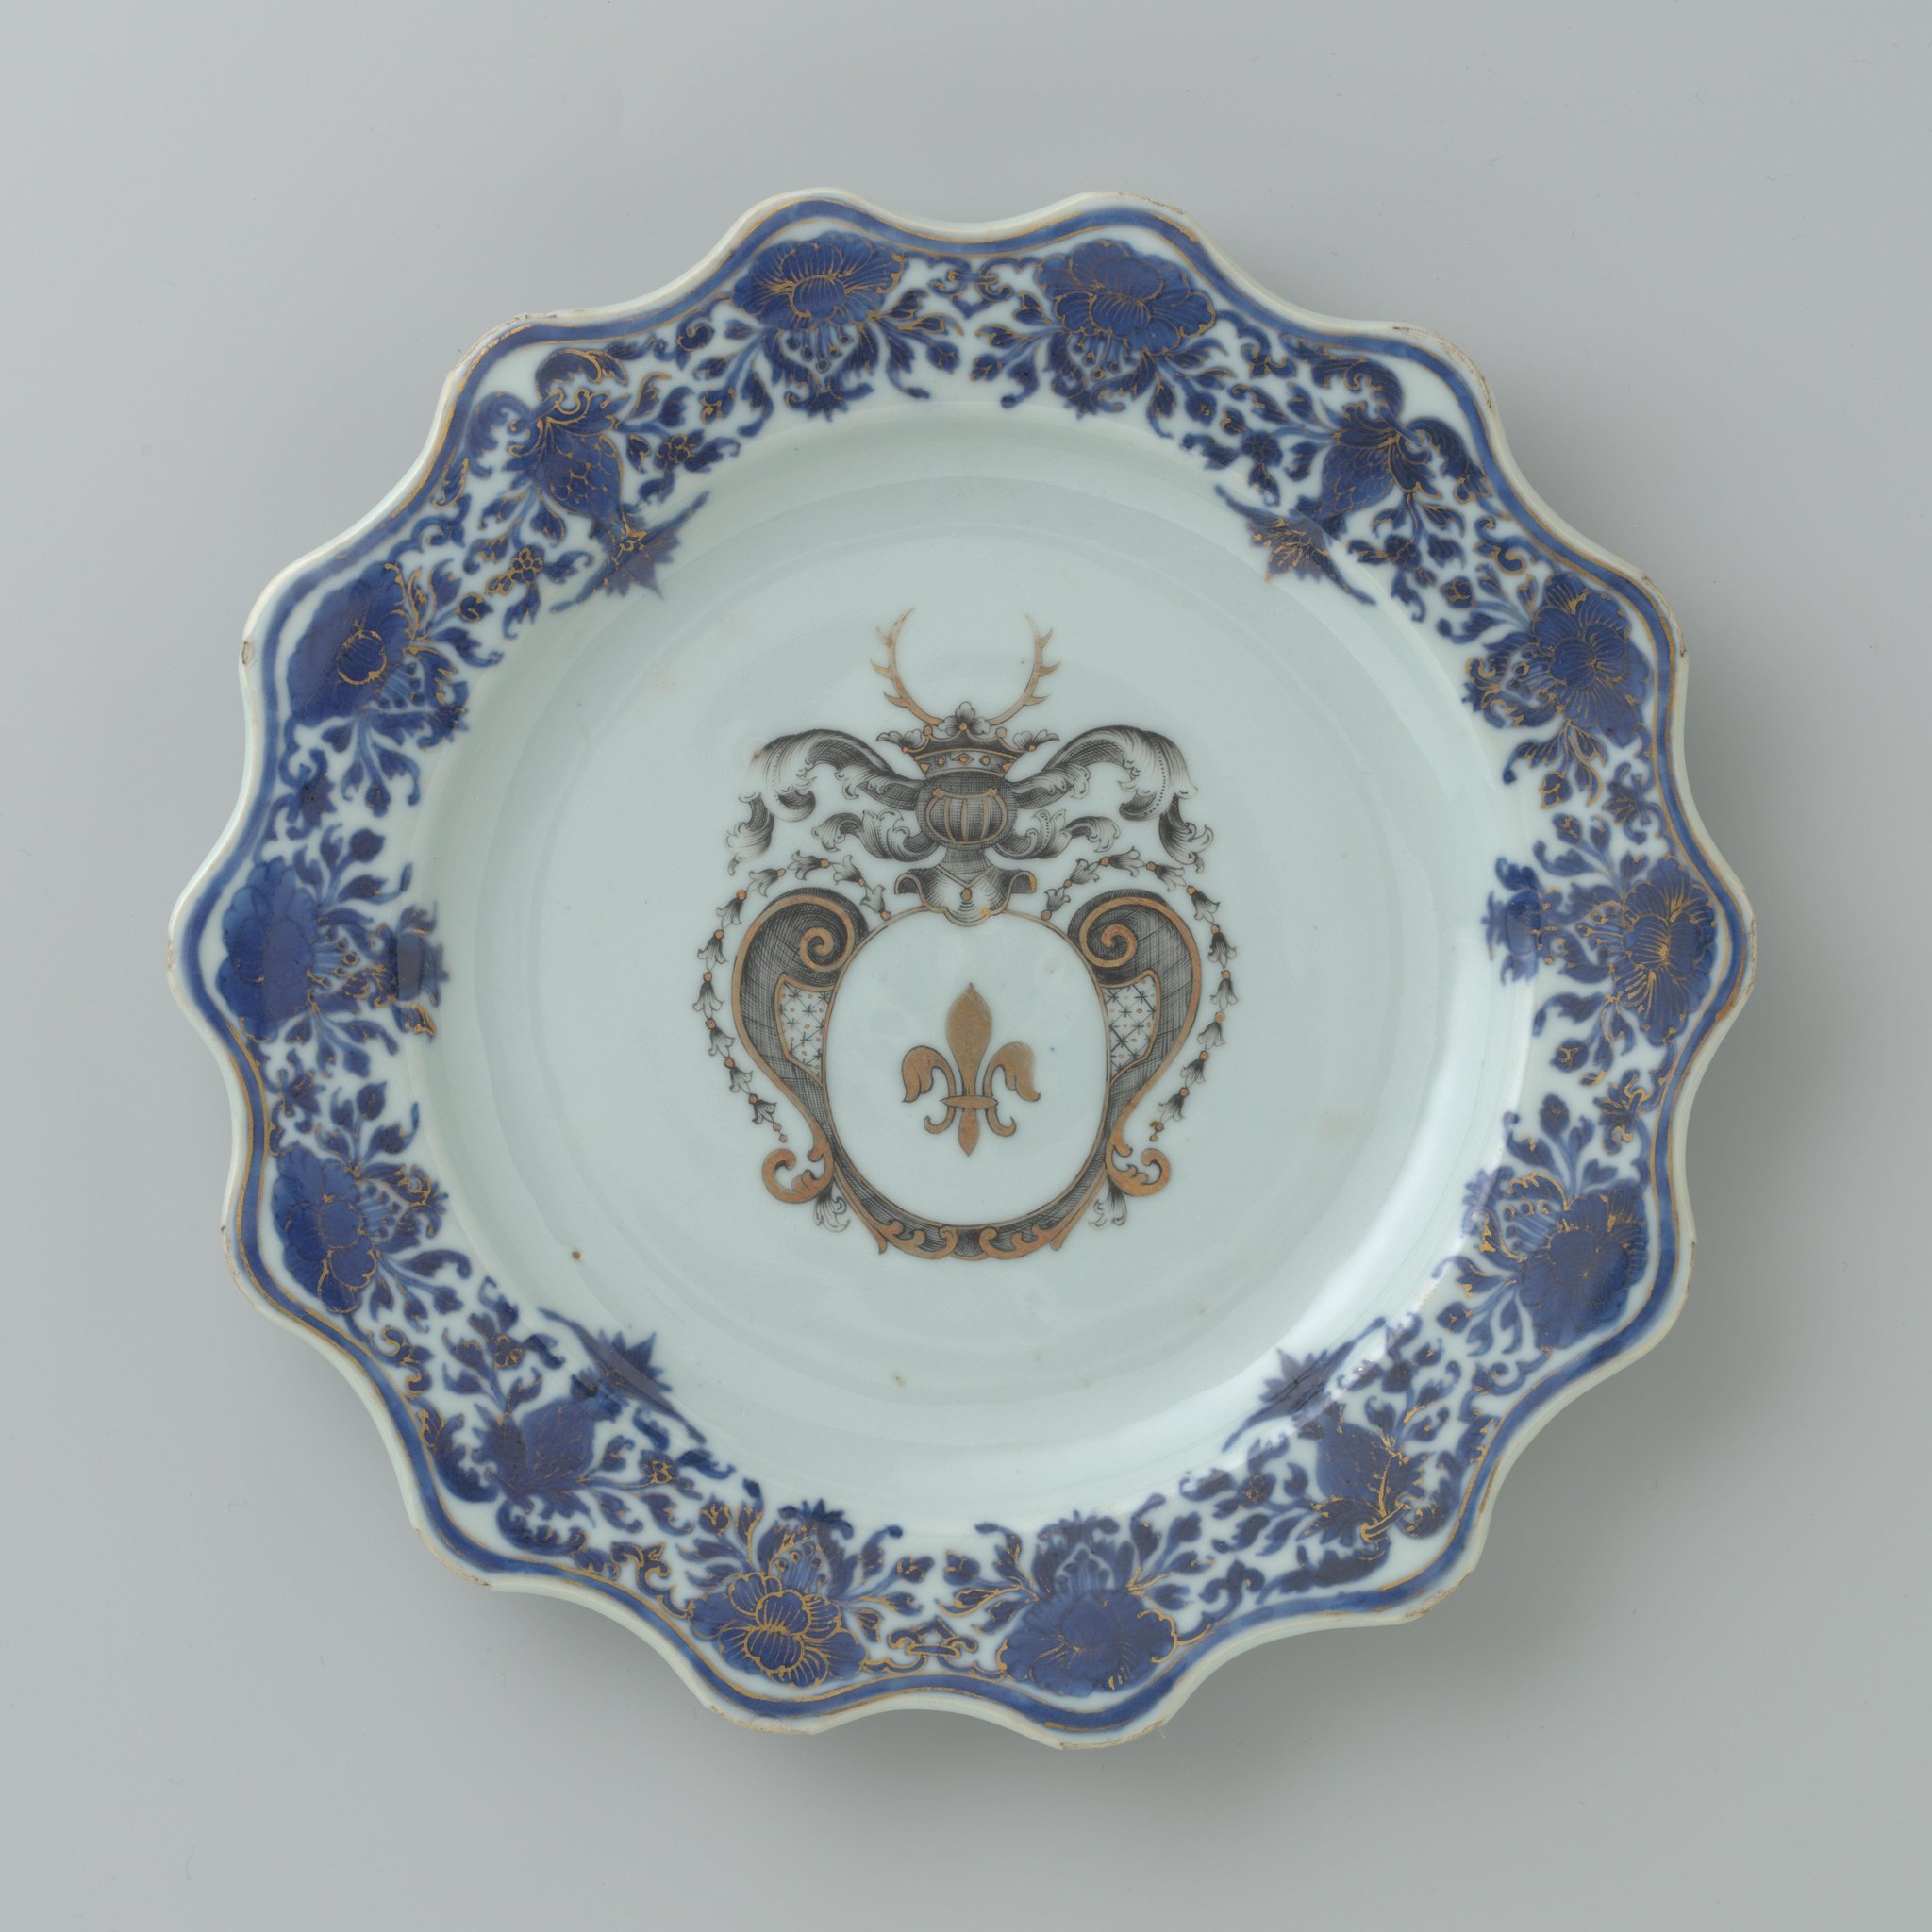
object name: plate dish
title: Dessertbord met het wapen van de familie Swellengrebel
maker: Anonymous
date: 1740-1750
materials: cobalt, glaze, gold, paint, porcelain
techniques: firing, gilding, turning, vitrification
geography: china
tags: utrecht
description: Klein bord op een standring en met een golvende rand. Beschilderd in onderglazuur blauw en met zwart en goud op het glazuur. Rond de rand een brede band met bandwerk en bloemranken in blauw met goudhet wapen van de familie Swellengrebel in zwart en goud: Franse lelie op een ovaal schild en een gewei boven een kroon als helmteken. Wapenporselein in blauw-wit en emailkleuren.